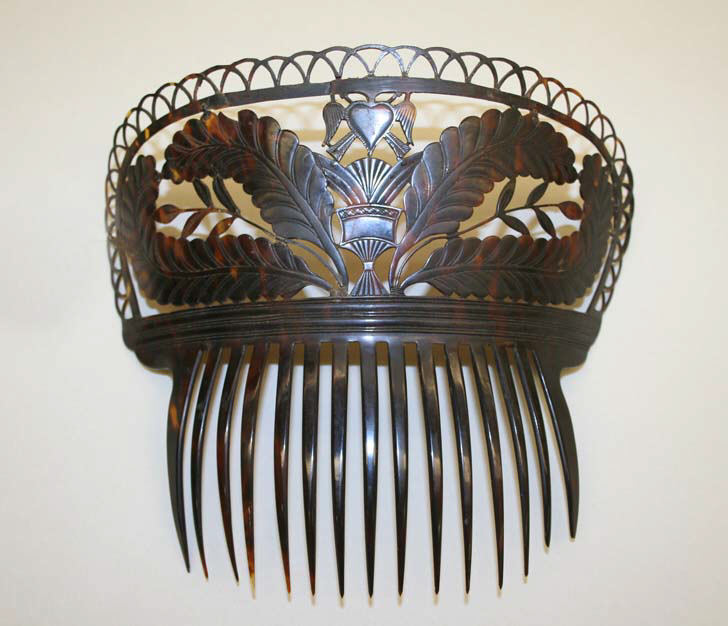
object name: comb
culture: argentinean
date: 1830-1849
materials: shell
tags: leaves